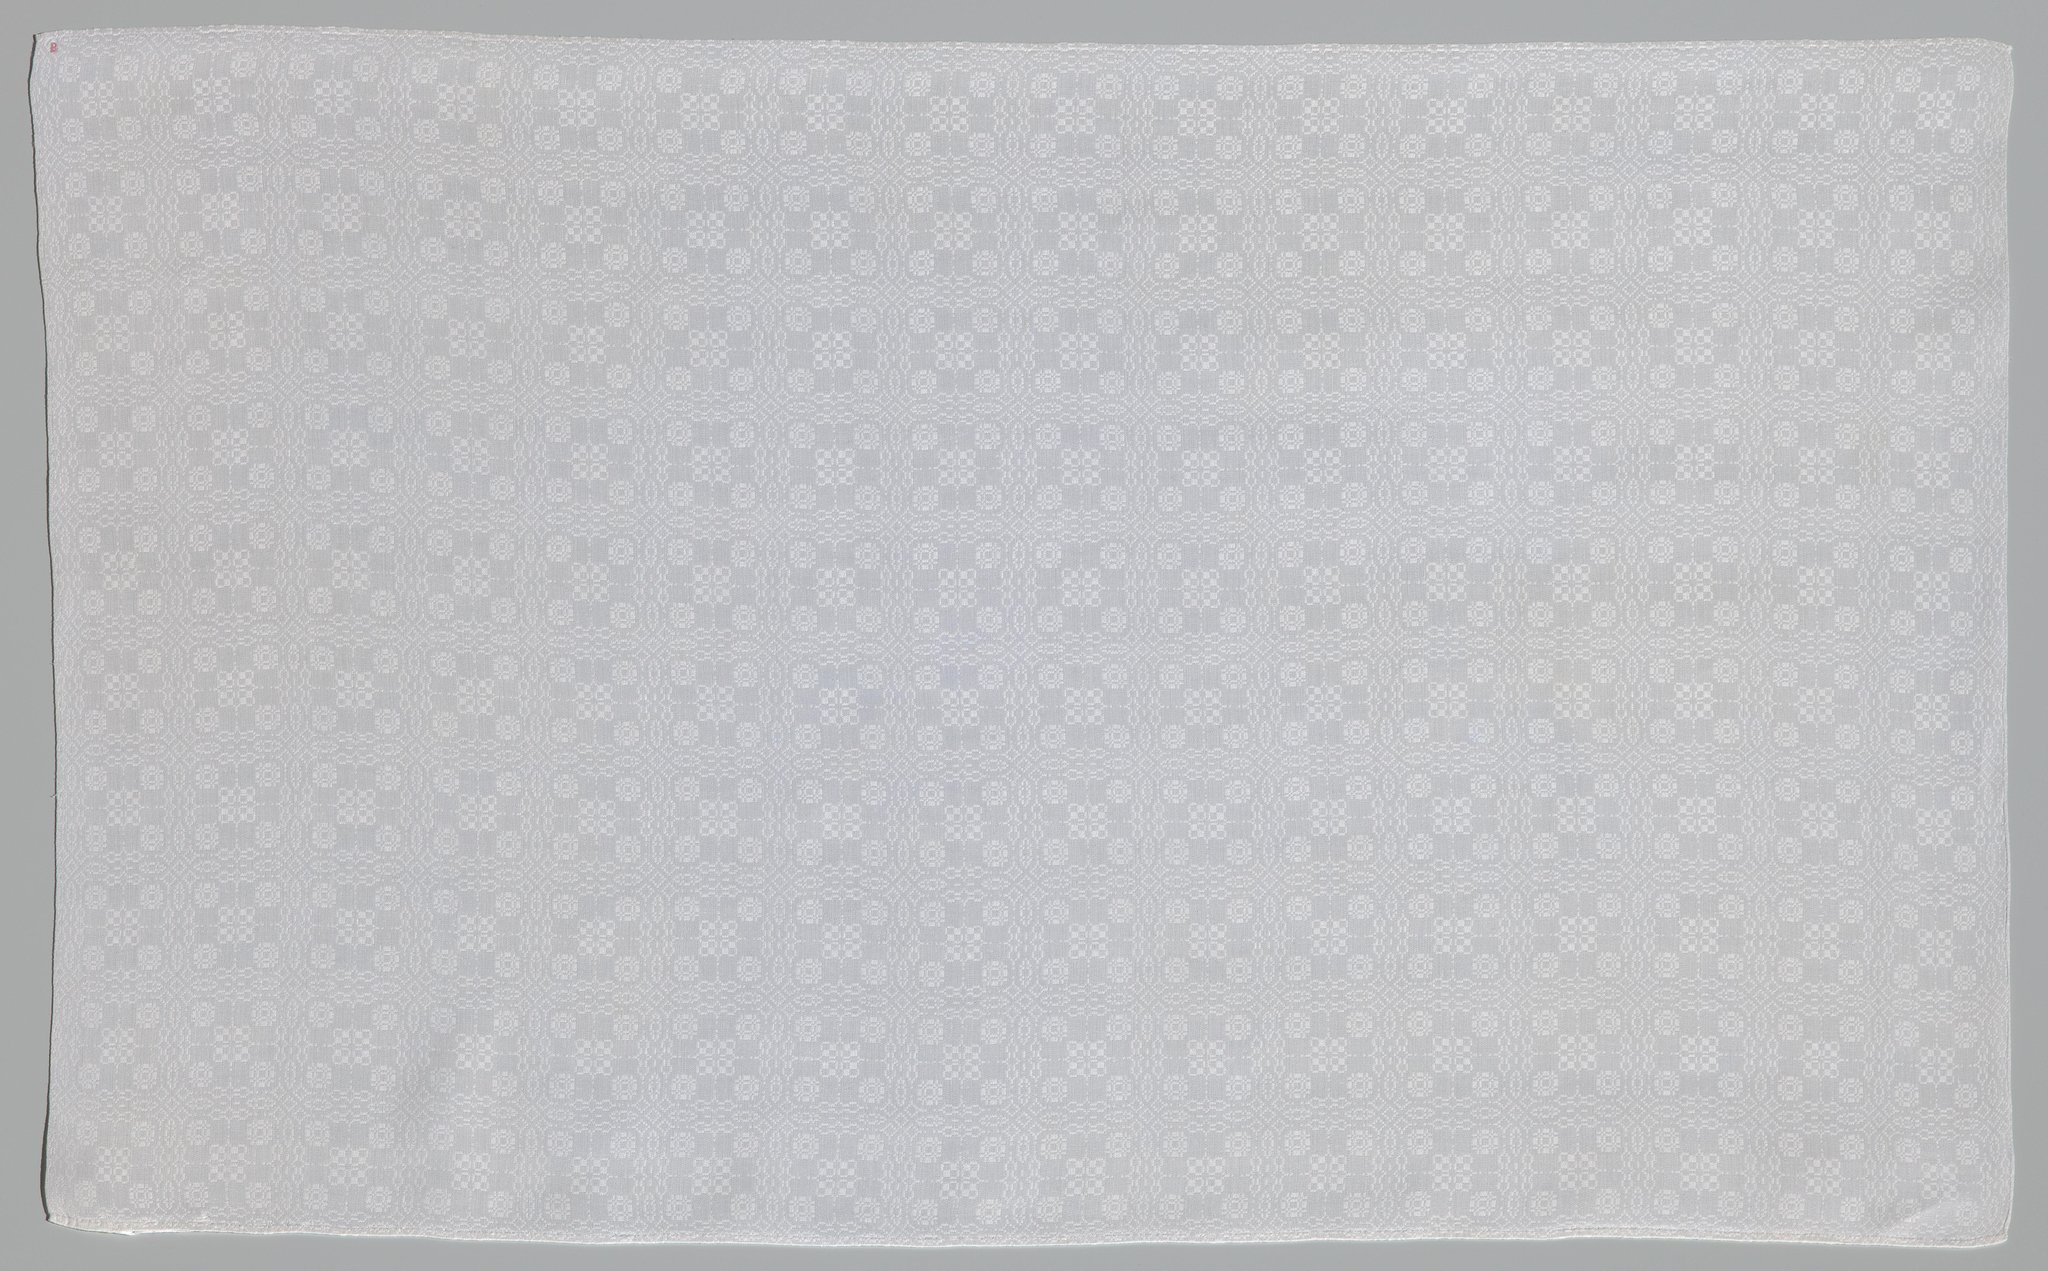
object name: napkin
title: Pellen: elkaar snijdende rijen van ruiten die vierkanten vormen waarbinnen vijf blokken. Merk in rood: B 18.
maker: Anonymous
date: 1675-1725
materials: linen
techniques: weave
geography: north brabant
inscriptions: mark: ‘B’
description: Servet van pellendamast. Elkaar snijdende rijen van ruiten vormen vierkanten, waarbinnen vijf blokken. Het servet is gehalveerd. Het servet hoort bij twaalf servetten en een tafellaken.